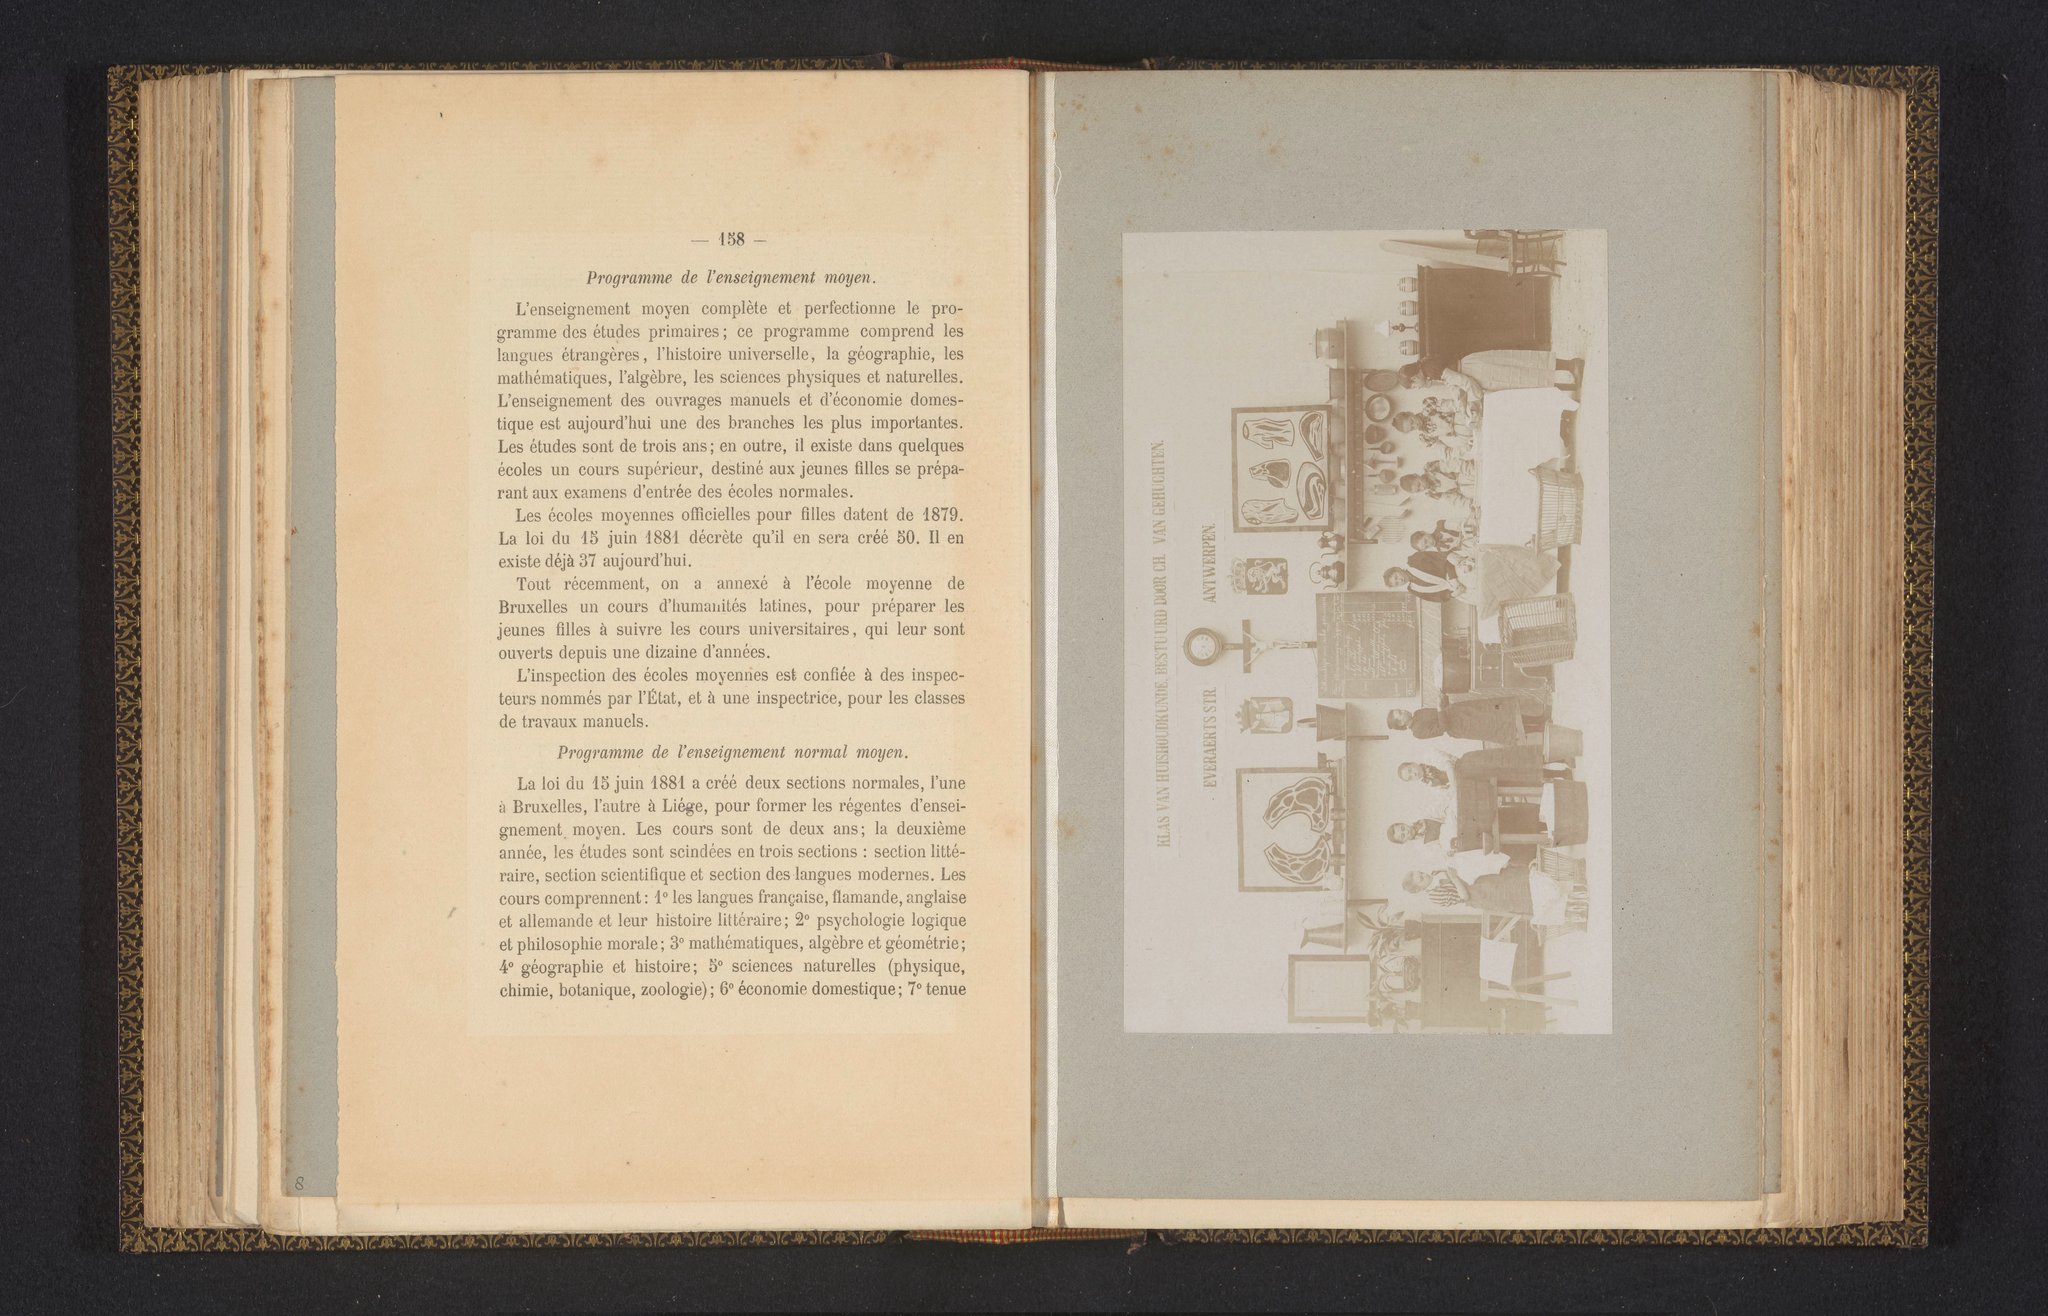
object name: page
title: Gezicht op een schoolklas van huishoudkunde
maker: Anonymous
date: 1888-1893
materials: photographic support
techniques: collodion silver print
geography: antwerp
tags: laundering, household chores, elementary school; class, form, antwerp